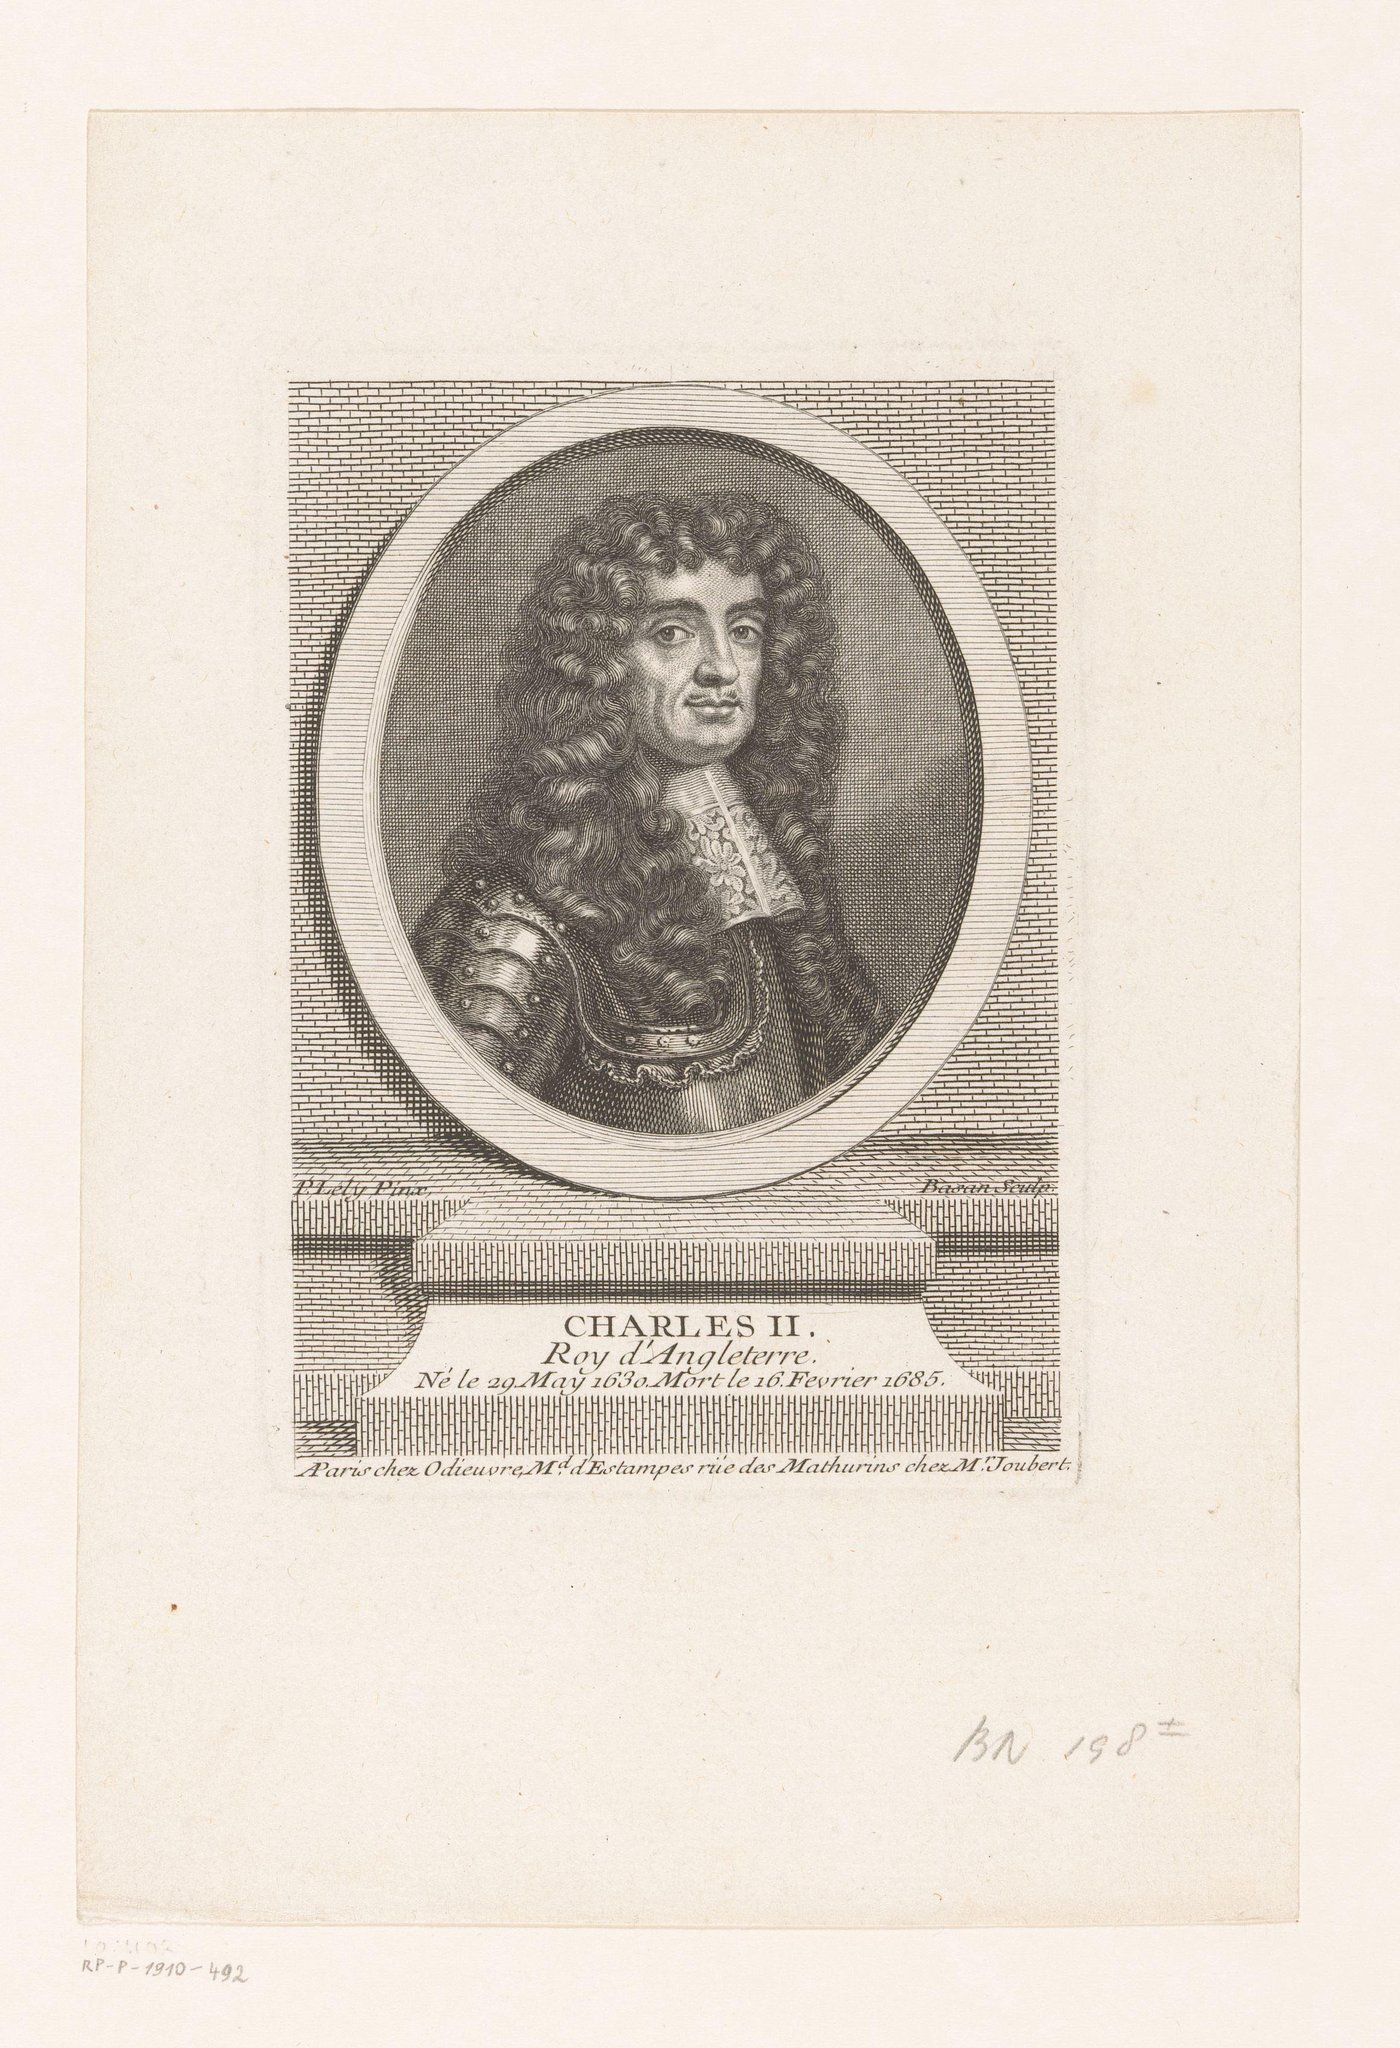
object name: print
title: Charles II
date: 1755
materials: paper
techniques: engraving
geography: france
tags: london, karel ii (koning van engeland), ornament ~ medallion, historical persons, ruler, sovereign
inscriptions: collector's mark: Lugt 2228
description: Prent uit: Dreux du Radier, Jean-François. L'Europe illustré, contenant l'histoire abregée des souverains, des princes, des prélats, des ministres, (...) en Europe: dans le XVe. siècle compris, jusqu'à présent. Parijs: Michel Odieuvre en André-François Le Breton, 1755, dl. 2.